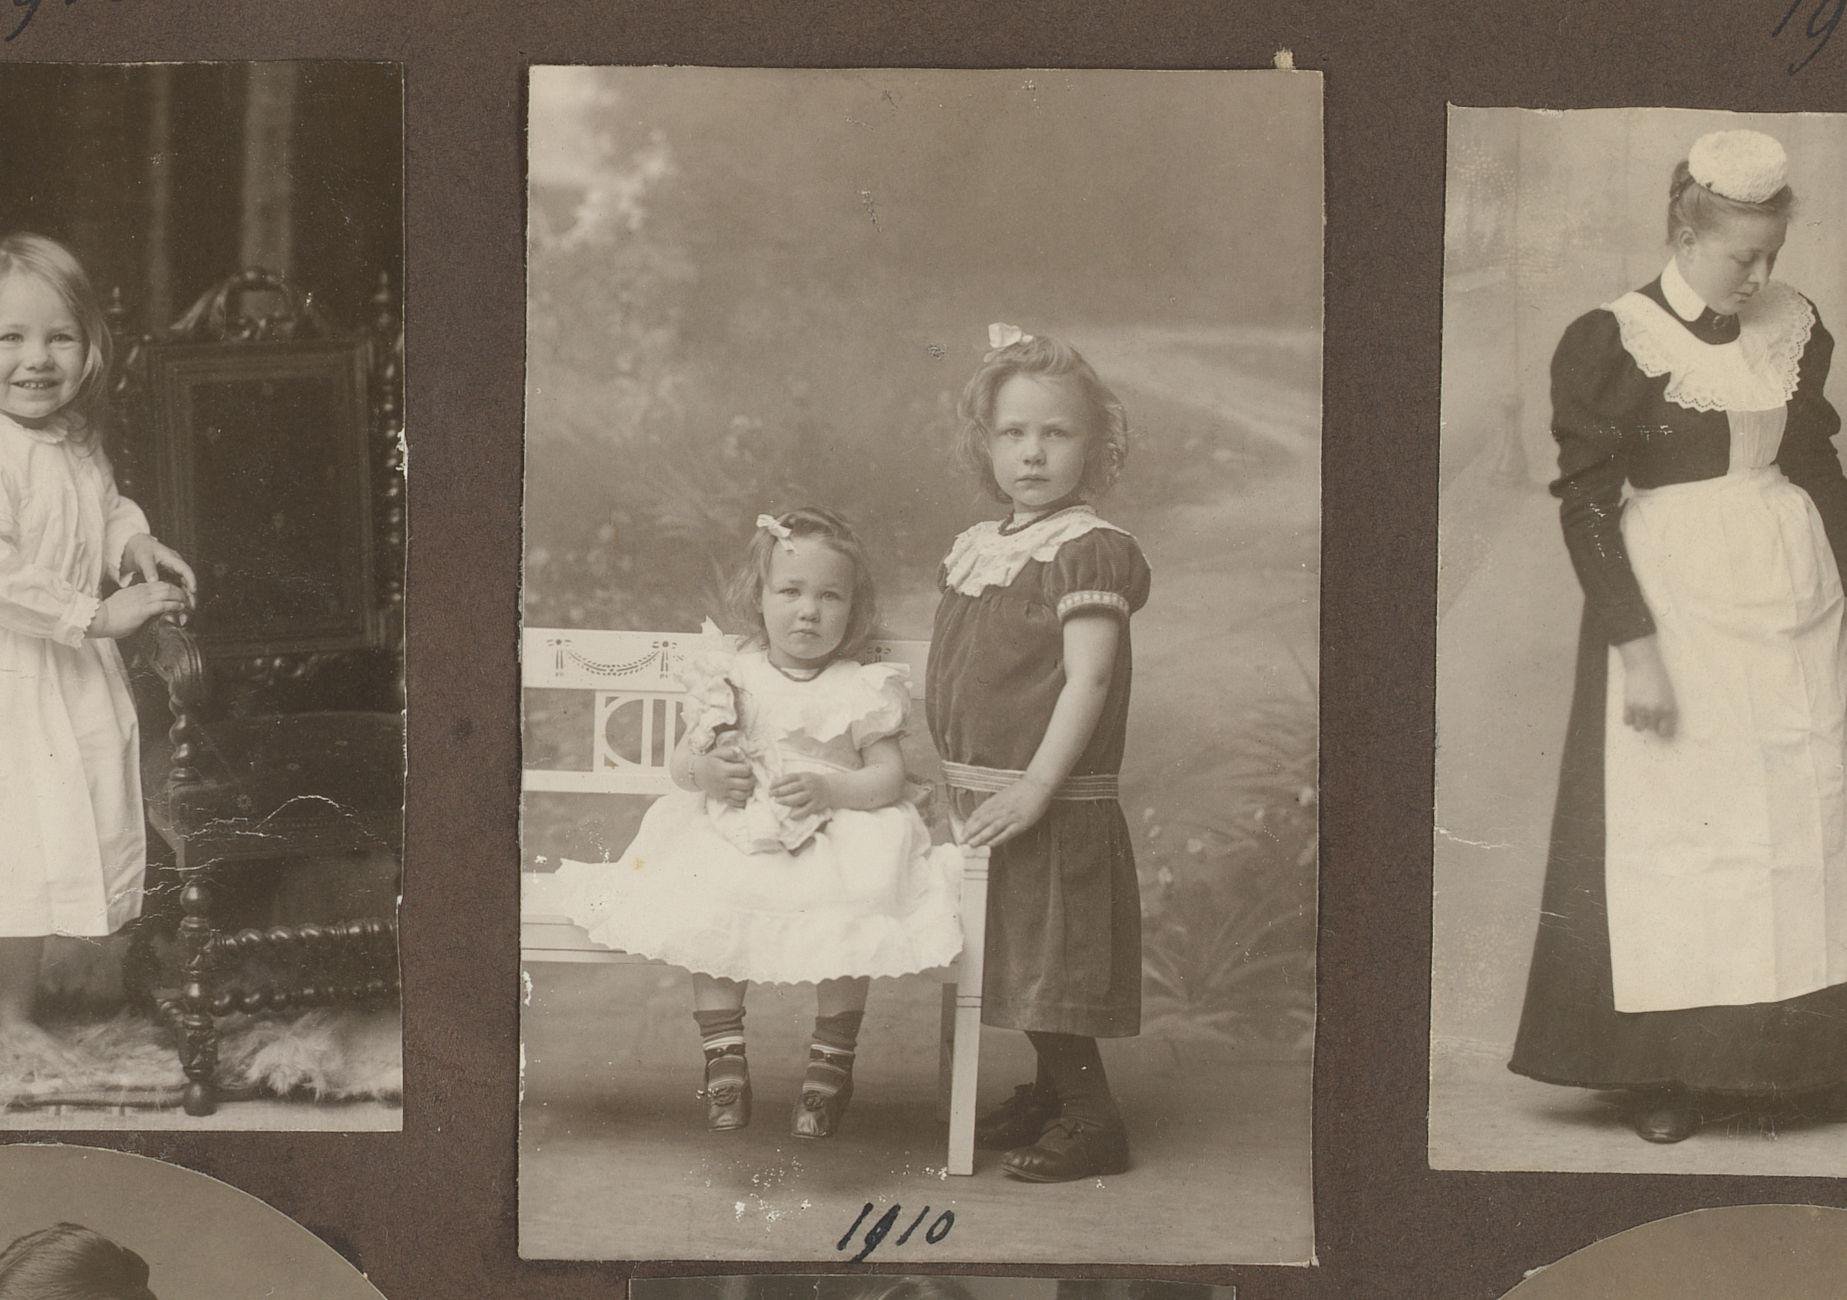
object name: photograph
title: Portret van Thea Diepenbrock zittend op een houten bank met en Joanna Diepenbrock staand ernaast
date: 1910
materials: paper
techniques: matte daylight collodion silver print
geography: netherlands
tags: amsterdam, historical persons - bb - woman, sisters (second degree family relationships)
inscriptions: date: ‘1910’